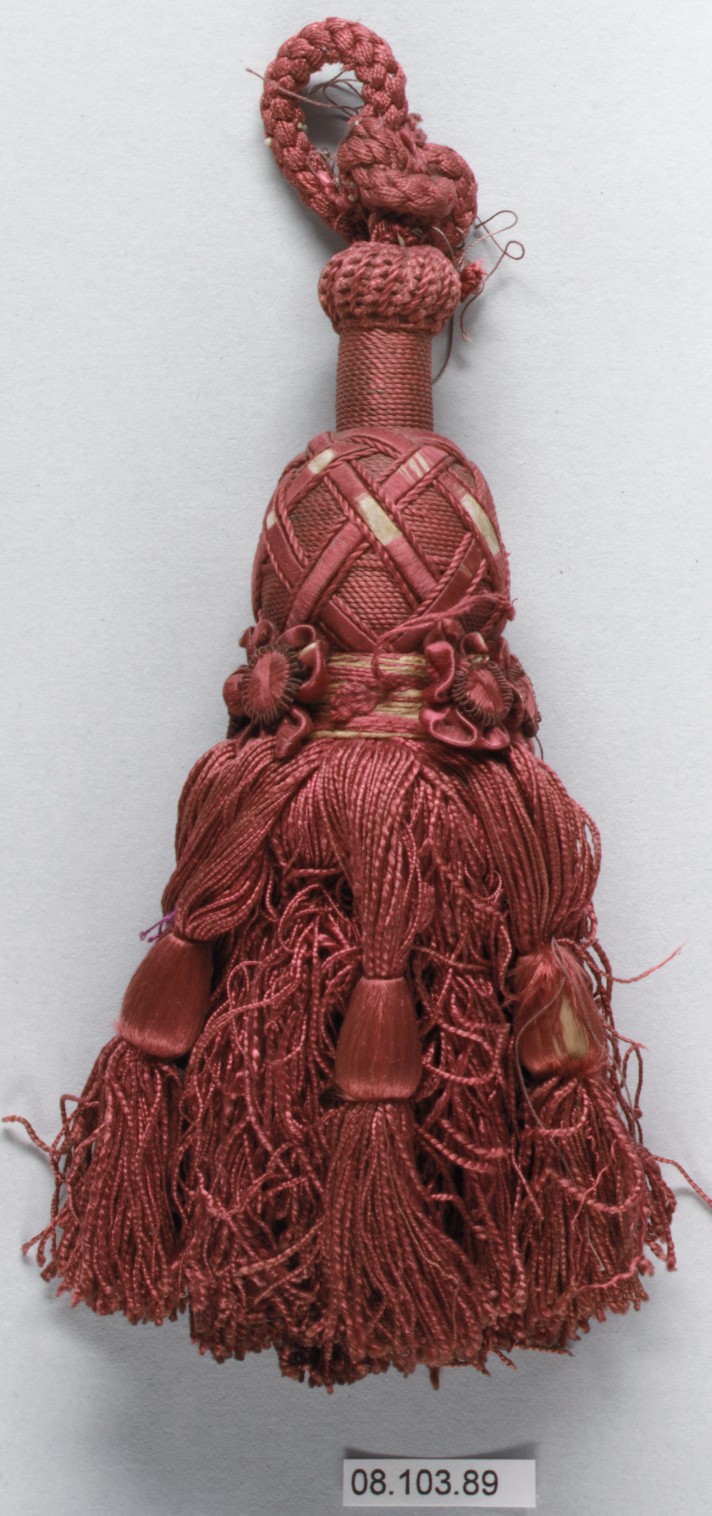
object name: tassel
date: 1801-1900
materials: silk